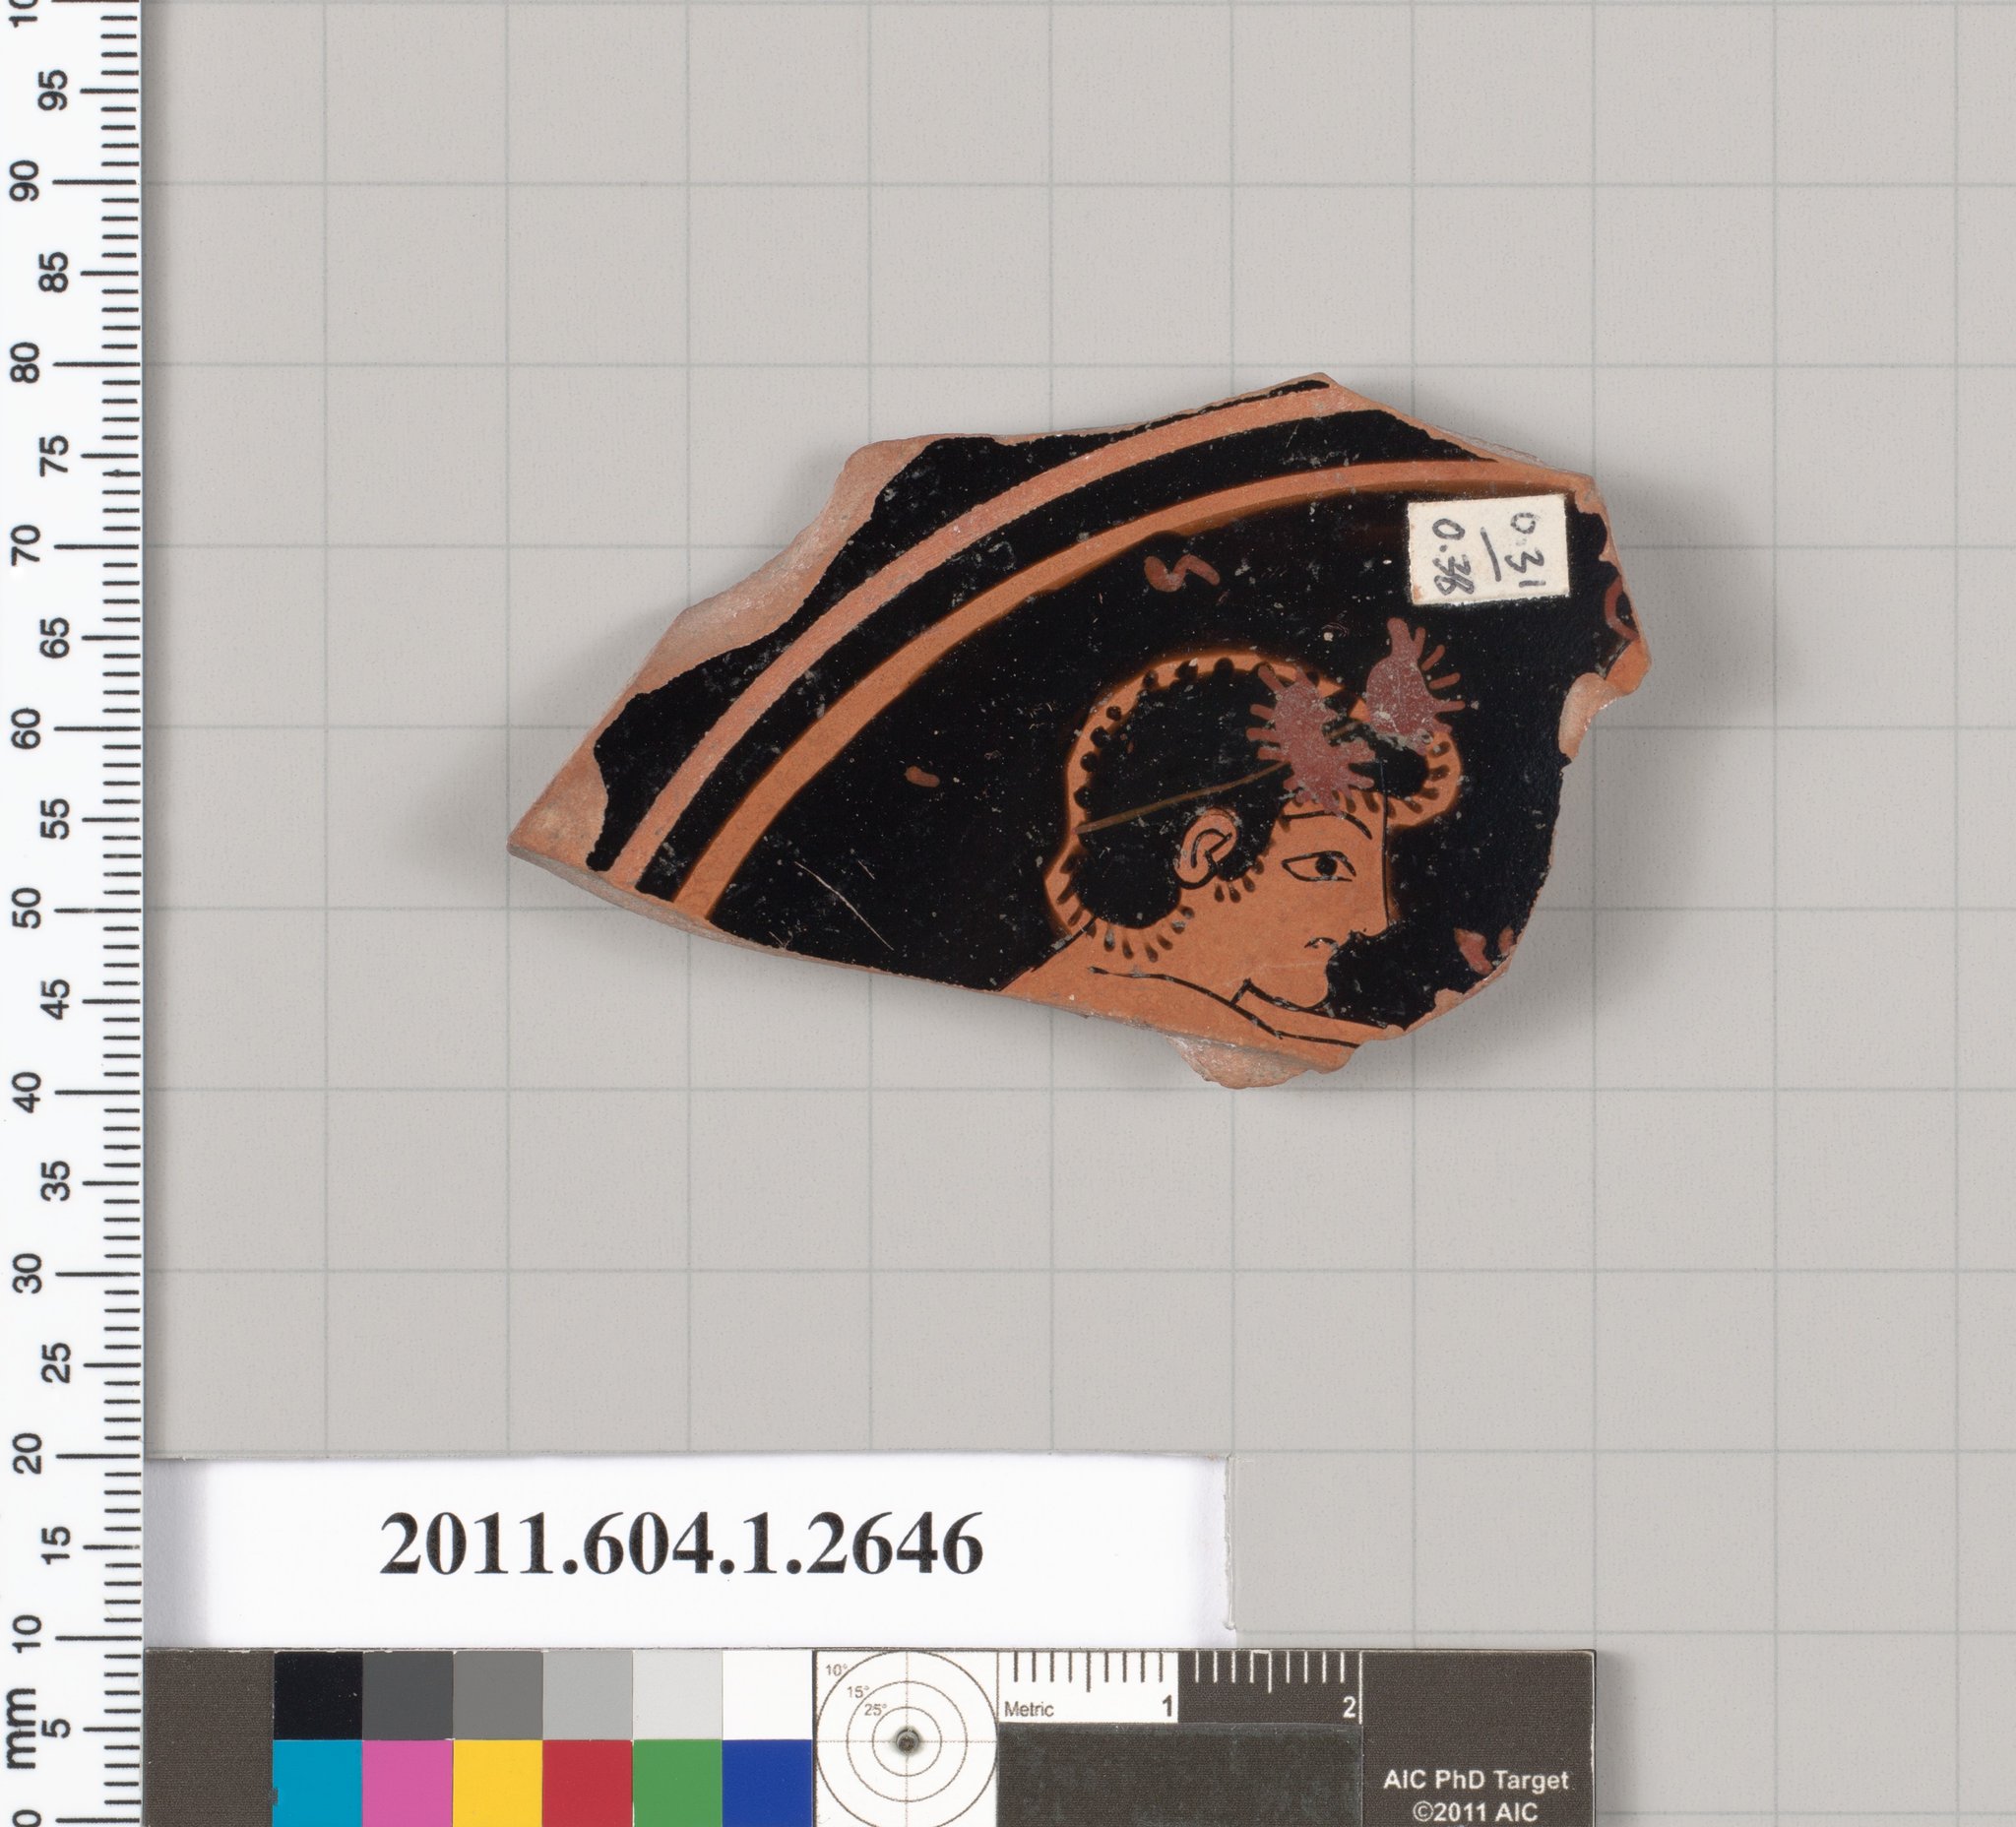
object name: kylix fragment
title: Terracotta fragment of a kylix (drinking cup)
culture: greek, attic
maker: chairias painter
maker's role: artist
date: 520-500 BCE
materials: terracotta